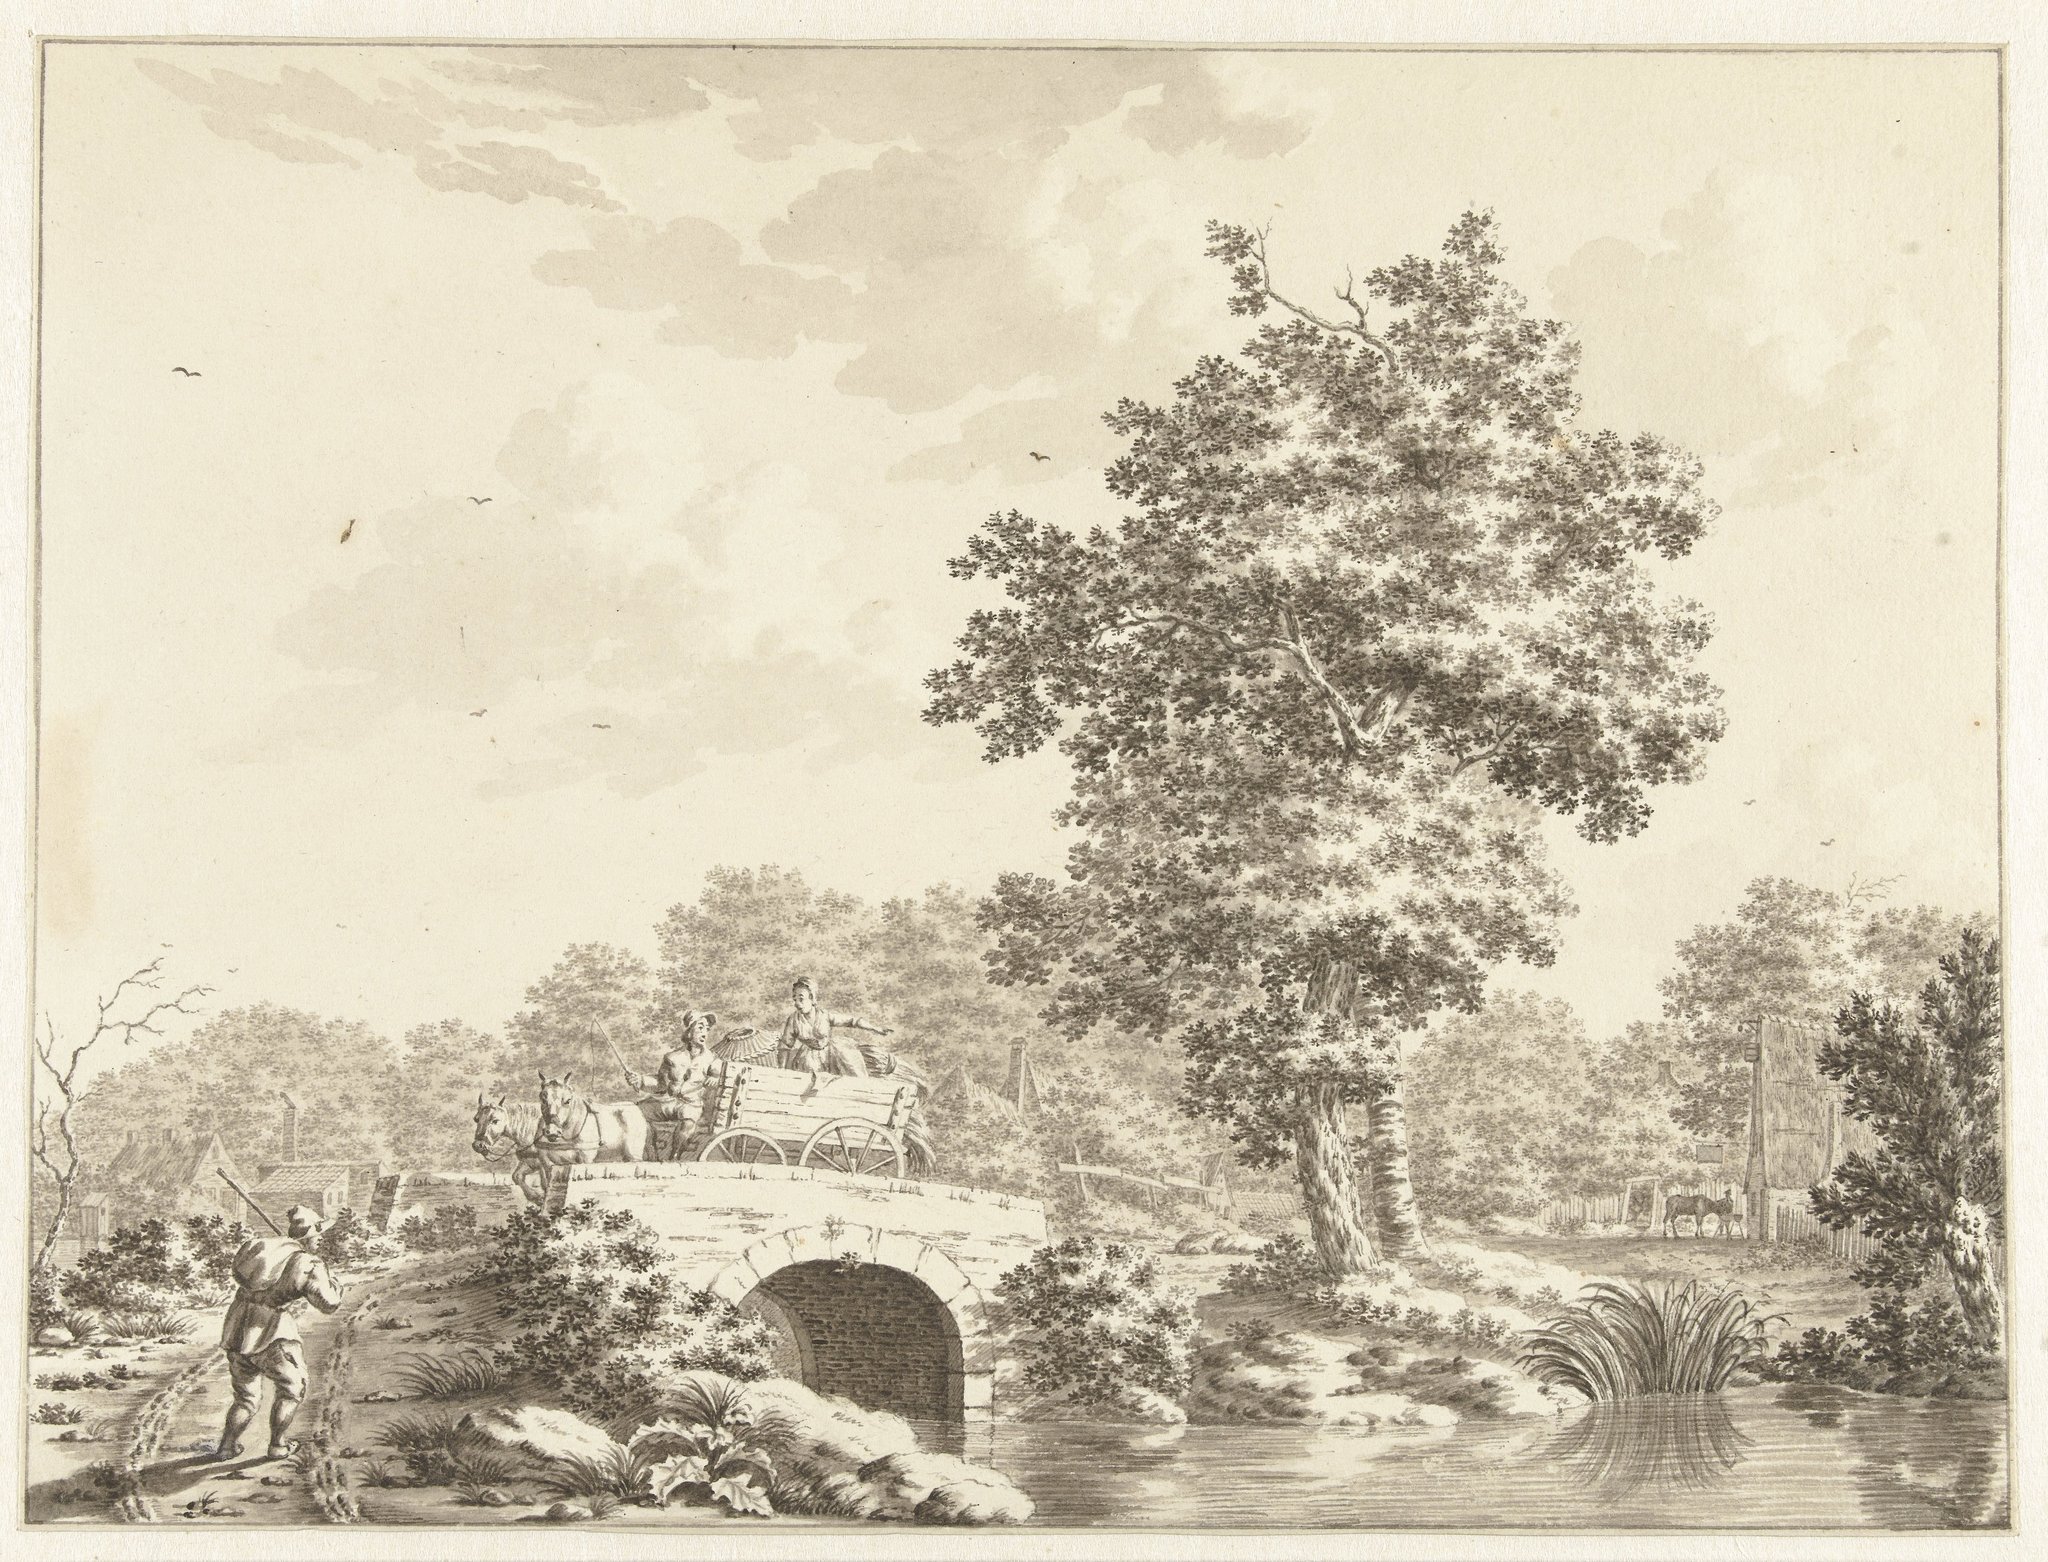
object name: drawing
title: Landschap met een kar op een stenen brug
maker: jan bruyn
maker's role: draughtsman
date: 1779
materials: ink, paper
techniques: brush, pen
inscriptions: date: ‘1779’